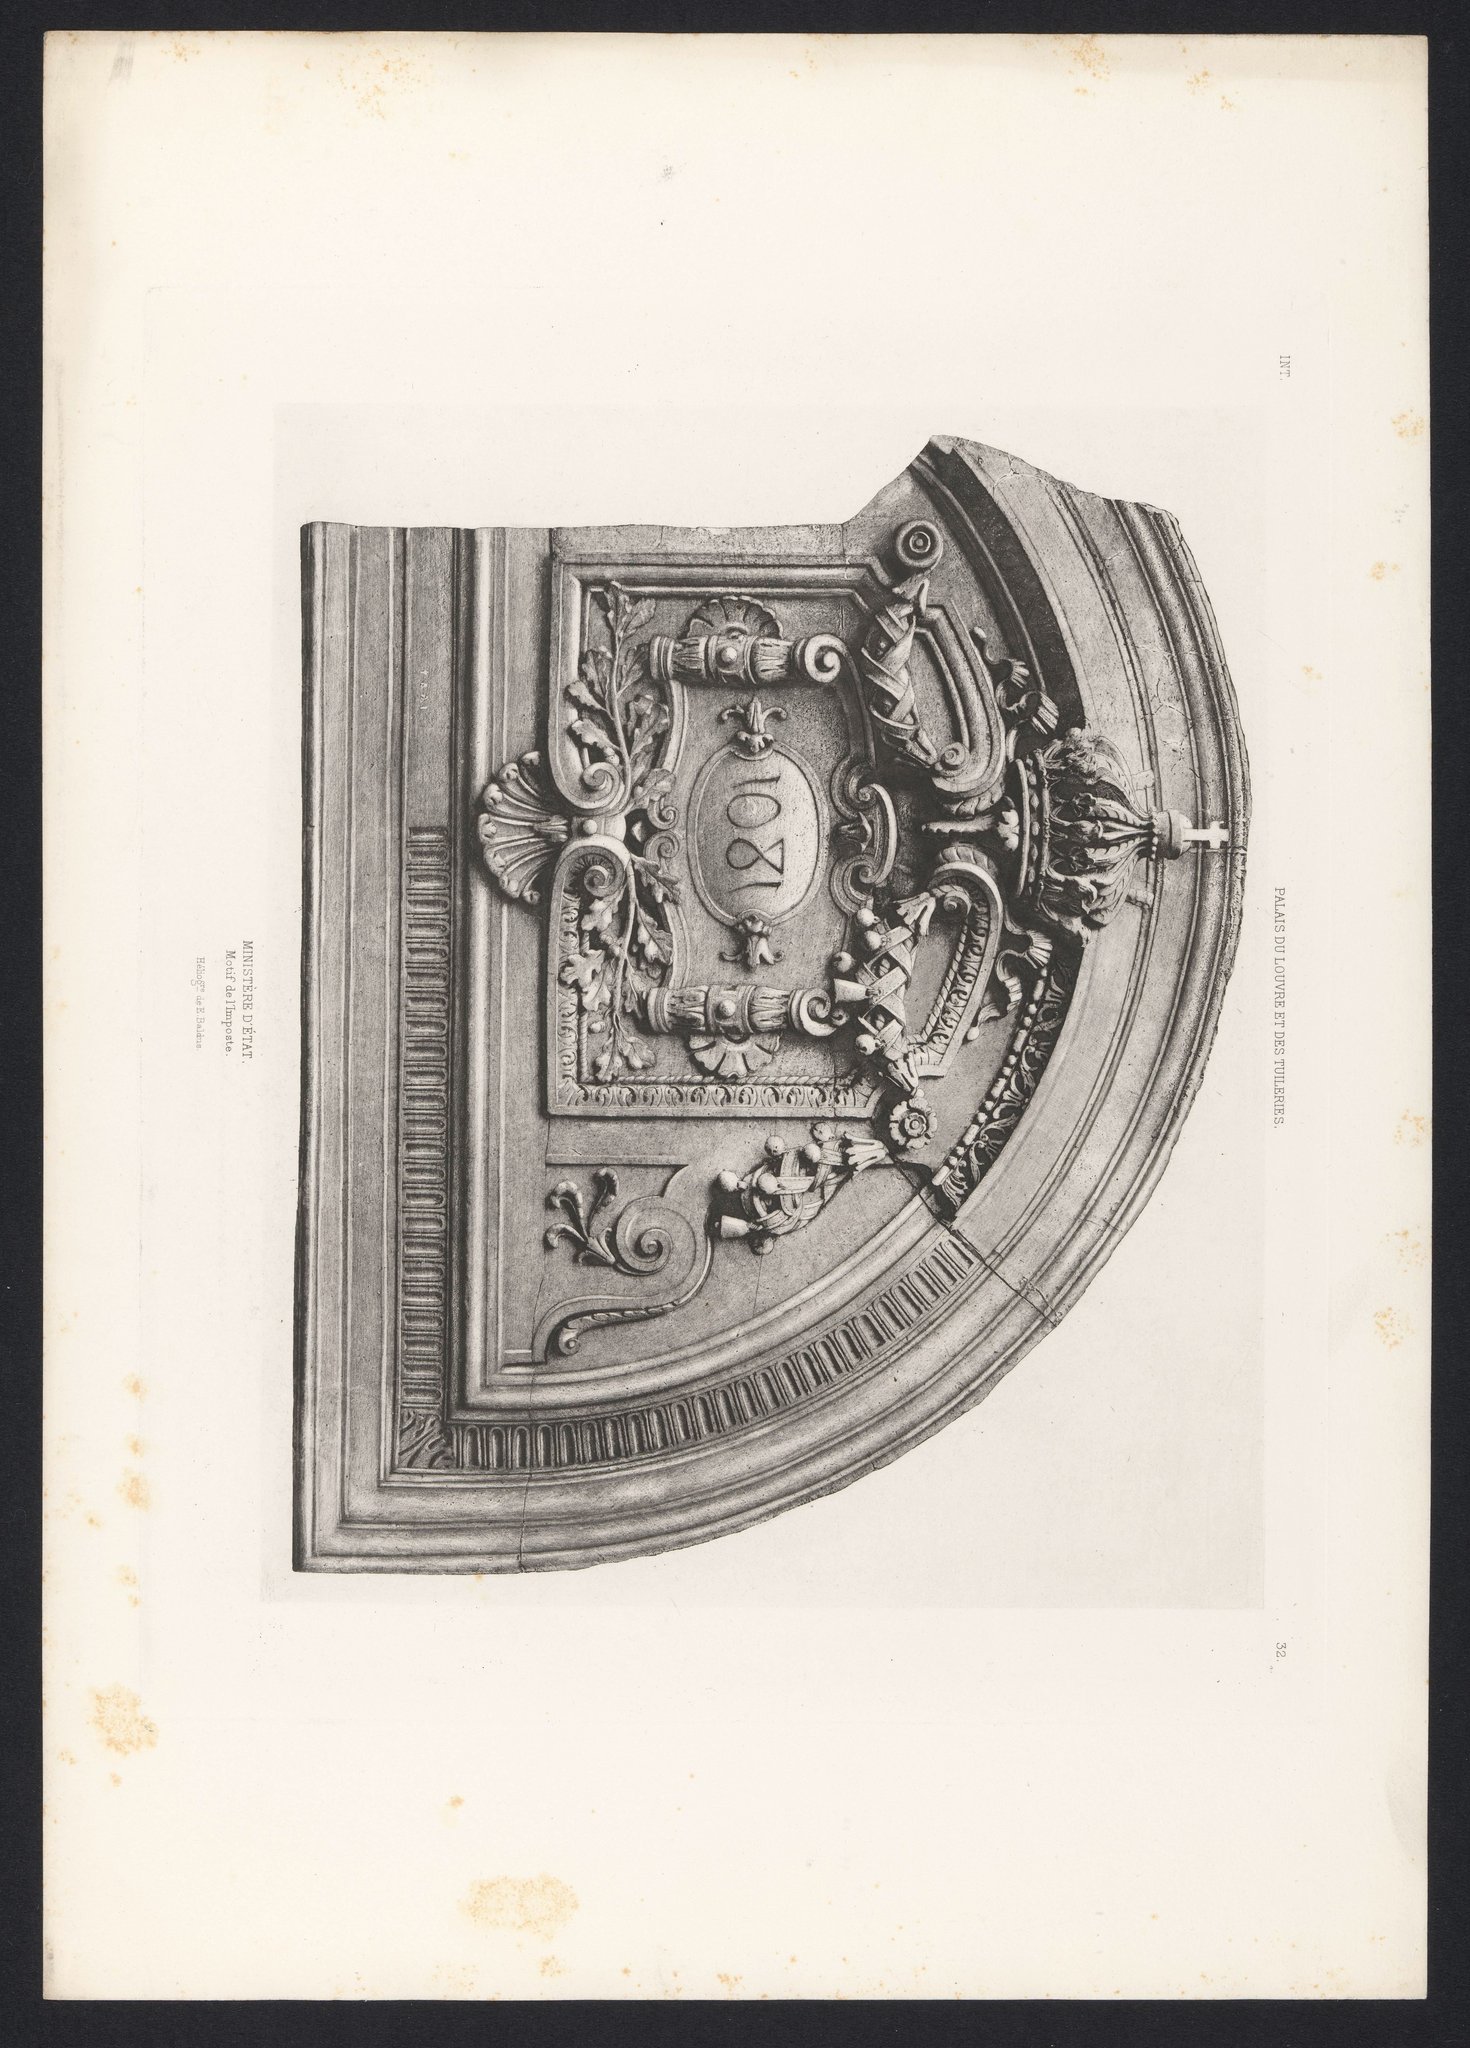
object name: photomechanical print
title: Ministère d’état. Motif de l'Imposte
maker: édouard denis baldus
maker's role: fotograaf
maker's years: 1813-1889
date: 1865-1870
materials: paper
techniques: photoaquatint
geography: france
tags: ornaments ~ art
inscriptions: number: ‘Int. 32’